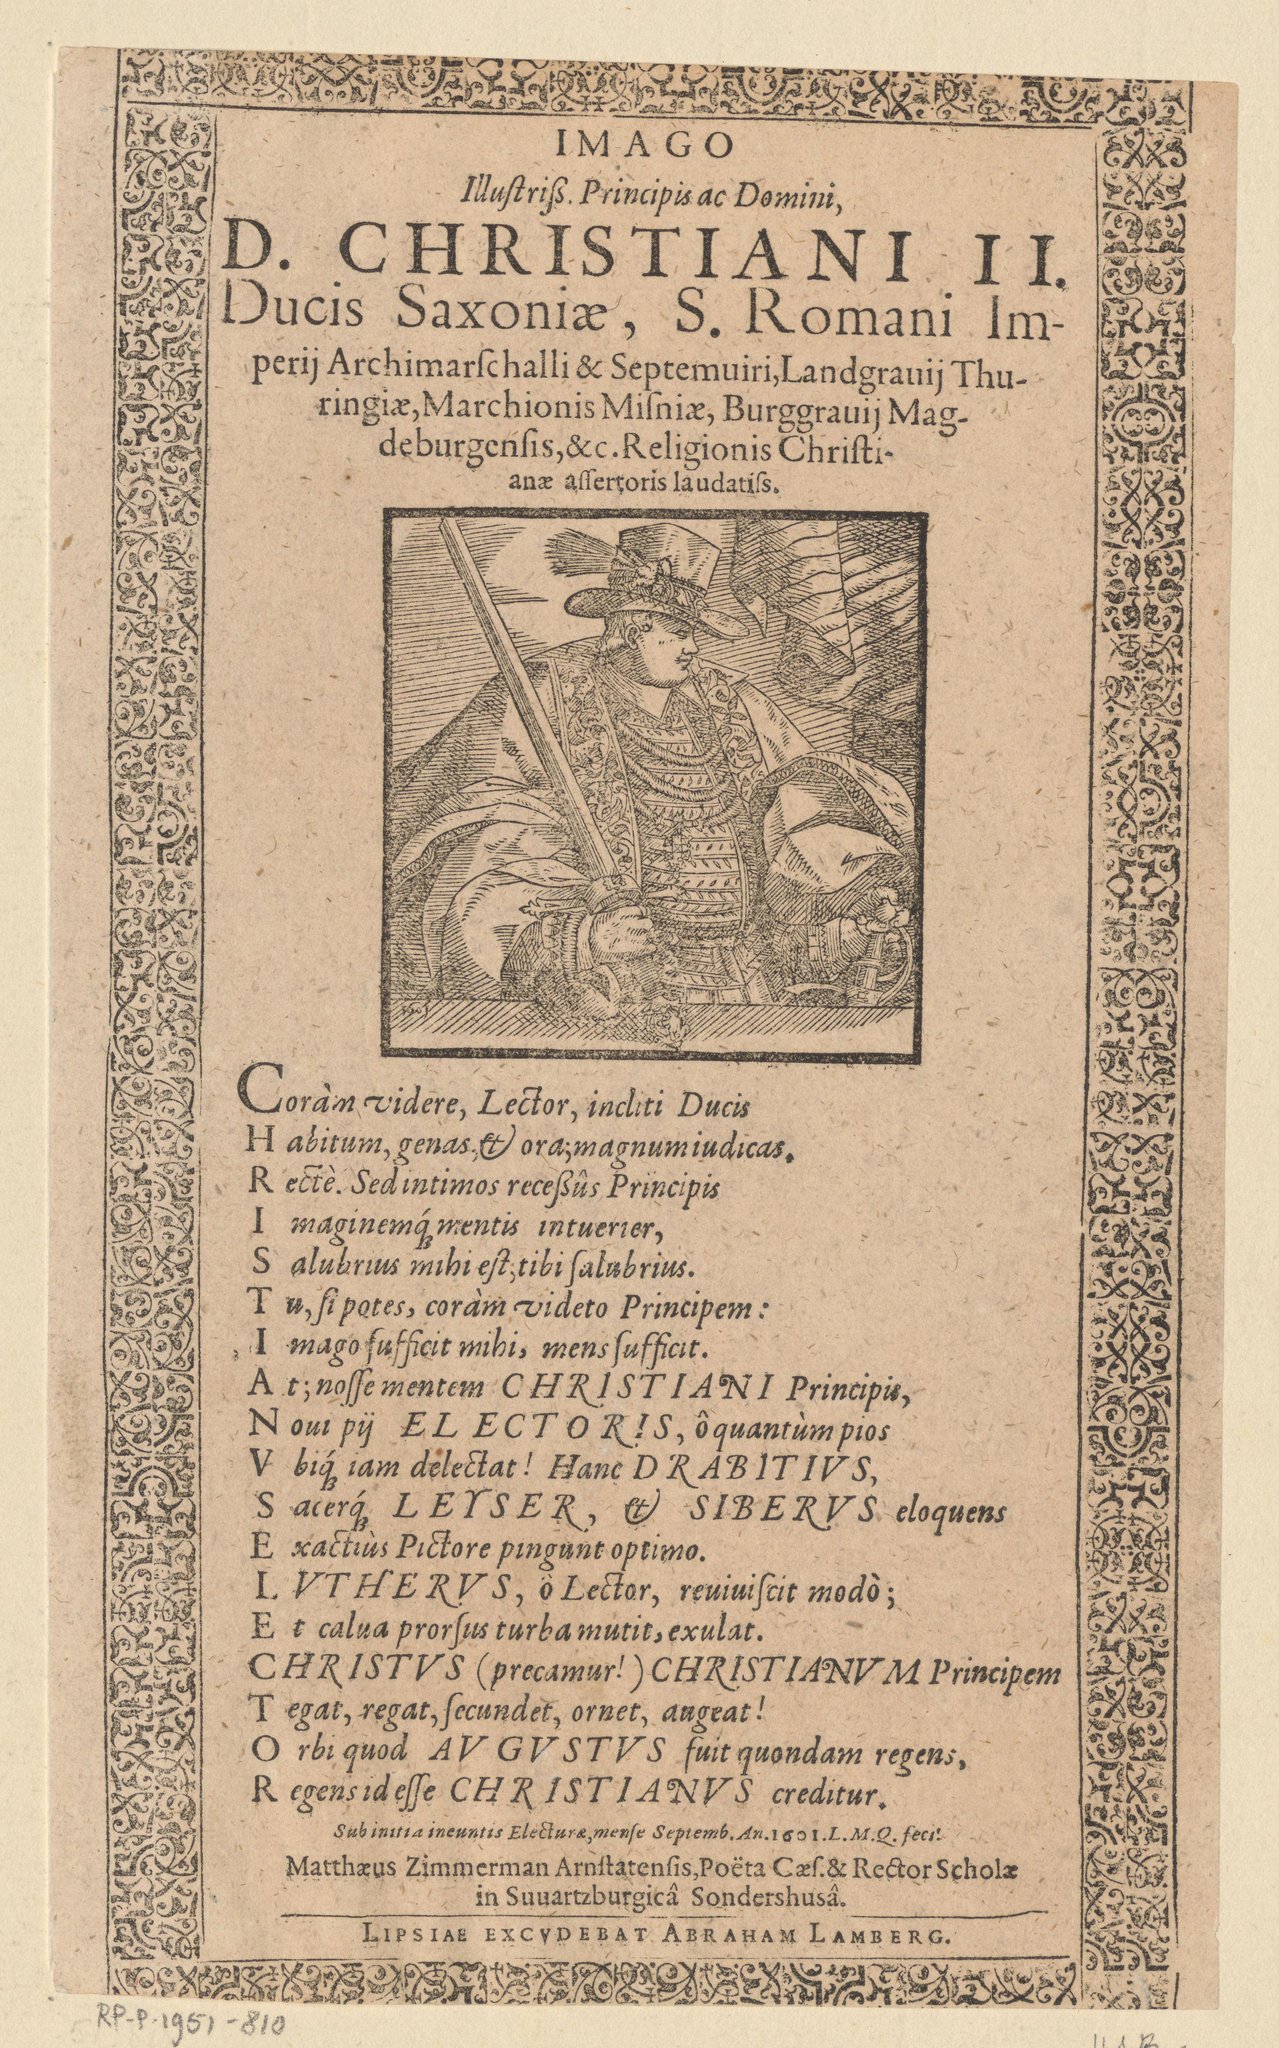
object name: print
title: Portret van Christiaan II van Saksen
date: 1601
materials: paper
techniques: letterpress printing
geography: leipzig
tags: historical persons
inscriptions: date